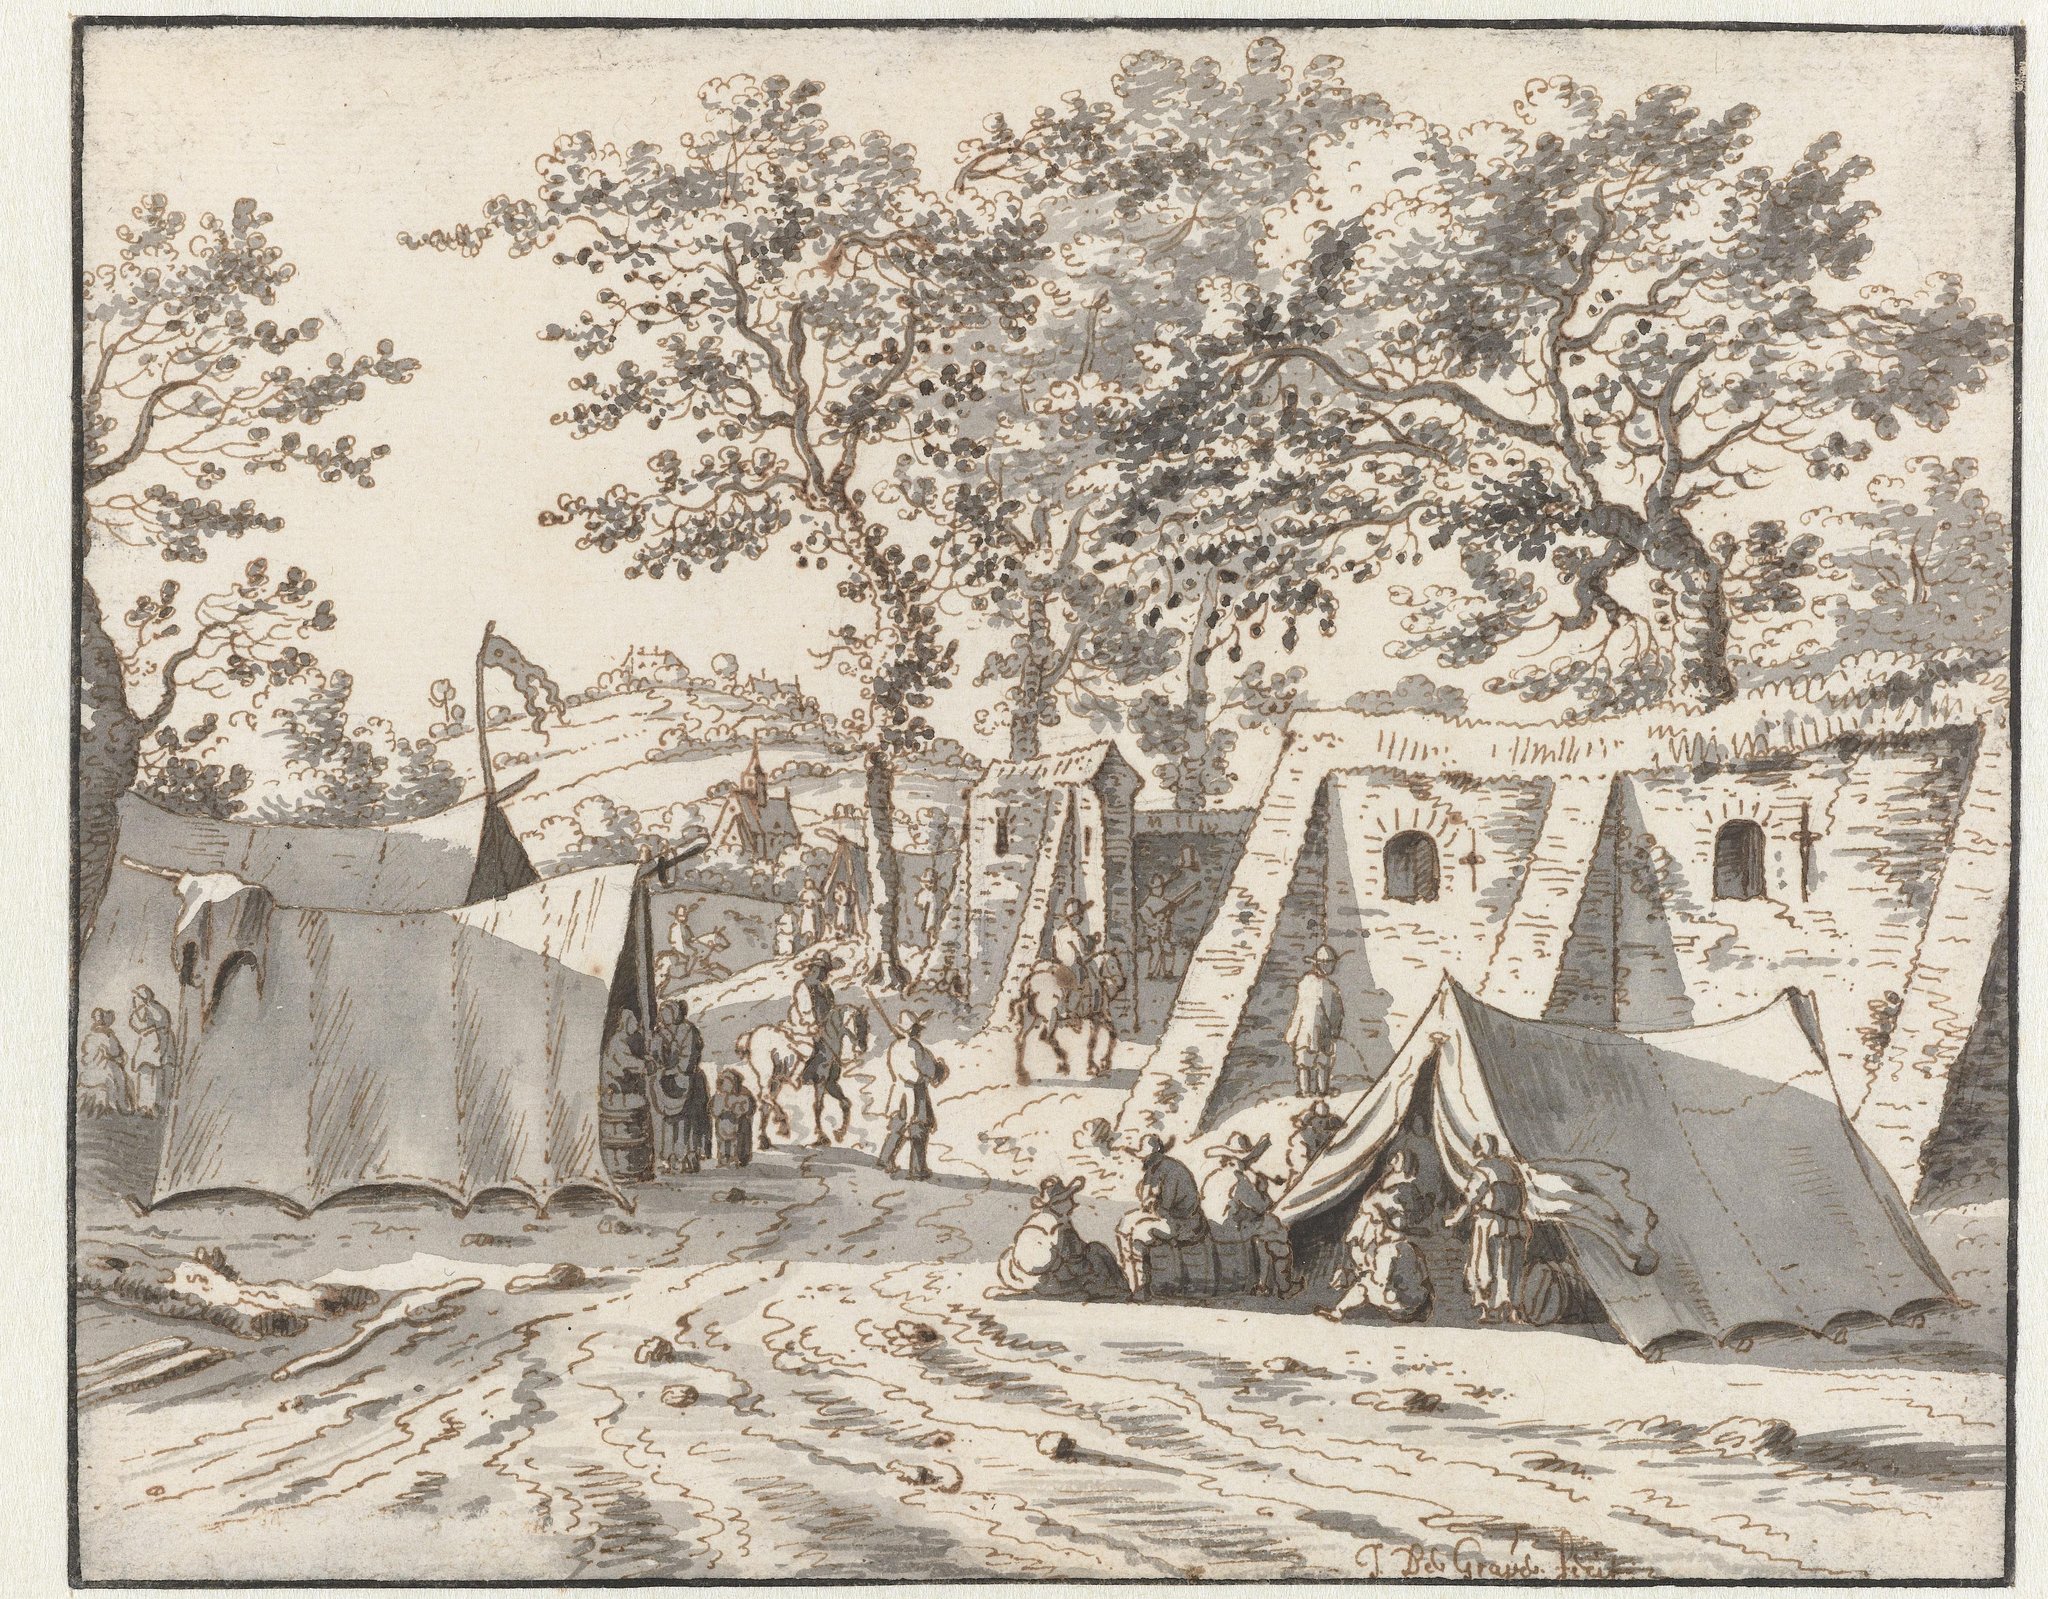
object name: drawing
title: View of an Encampment of the Army of Willem III near Leuven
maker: josua de grave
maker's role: draughtsman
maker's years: 1645-1712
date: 1675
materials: ink, paper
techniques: brush, pen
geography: leuven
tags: william iii (prince of orange and king of england, scotland, and ireland), (military) camp with tents, city-walls, louvain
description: Kampement van het leger van Willem III voor Leuven, 1675. Soldaten en tenten bij oude muren.